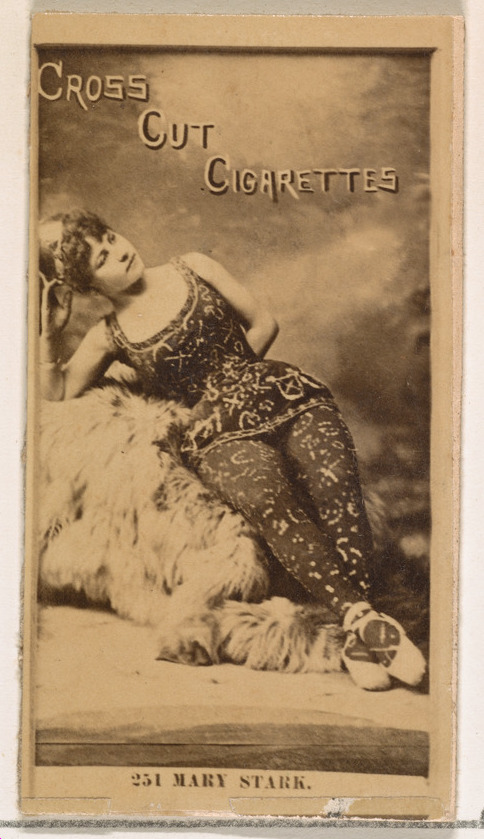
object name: print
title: Card Number 251, Mary Stark, from the Actors and Actresses series (N145-2) issued by Duke Sons & Co. to promote Cross Cut Cigarettes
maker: w. duke, sons & co.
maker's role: publisher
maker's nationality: american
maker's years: 1870-1920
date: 1880-1889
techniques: albumen silver print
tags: portraits,women,actresses